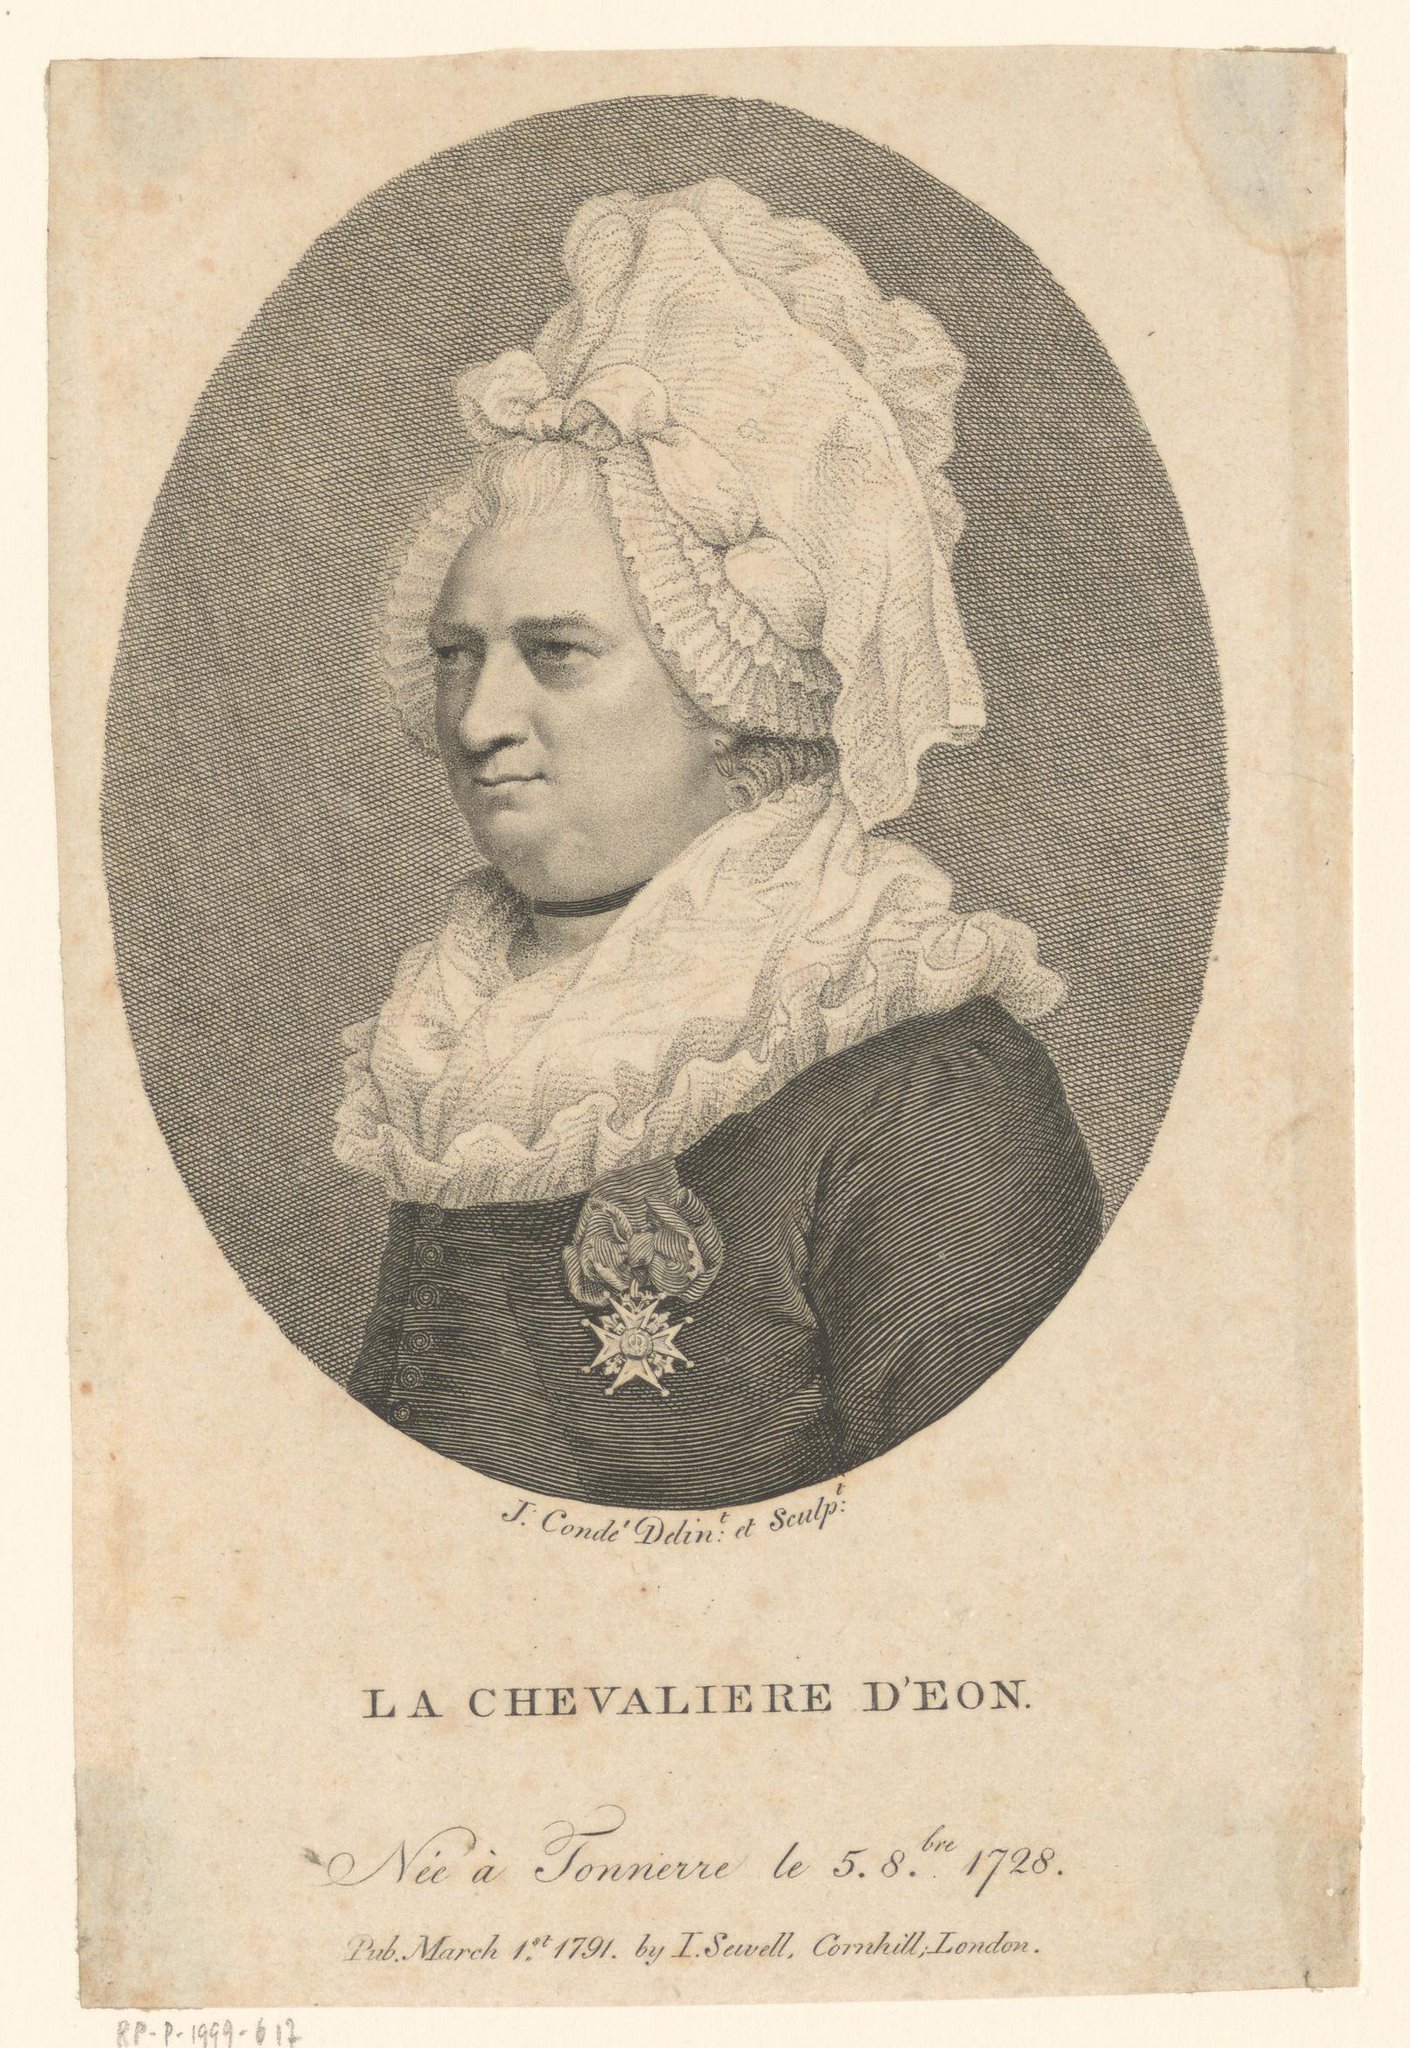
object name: print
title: Portret van Charles Geneviève Louis Auguste André Timothée d'Eon de Beaumont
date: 1791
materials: paper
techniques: etching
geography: london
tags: london, (military) espionage, historical persons, officer, medals and other marks of military honour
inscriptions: collector's mark: Lugt 2228, collector's mark: Lugt 2228, collector's mark: Lugt 2760